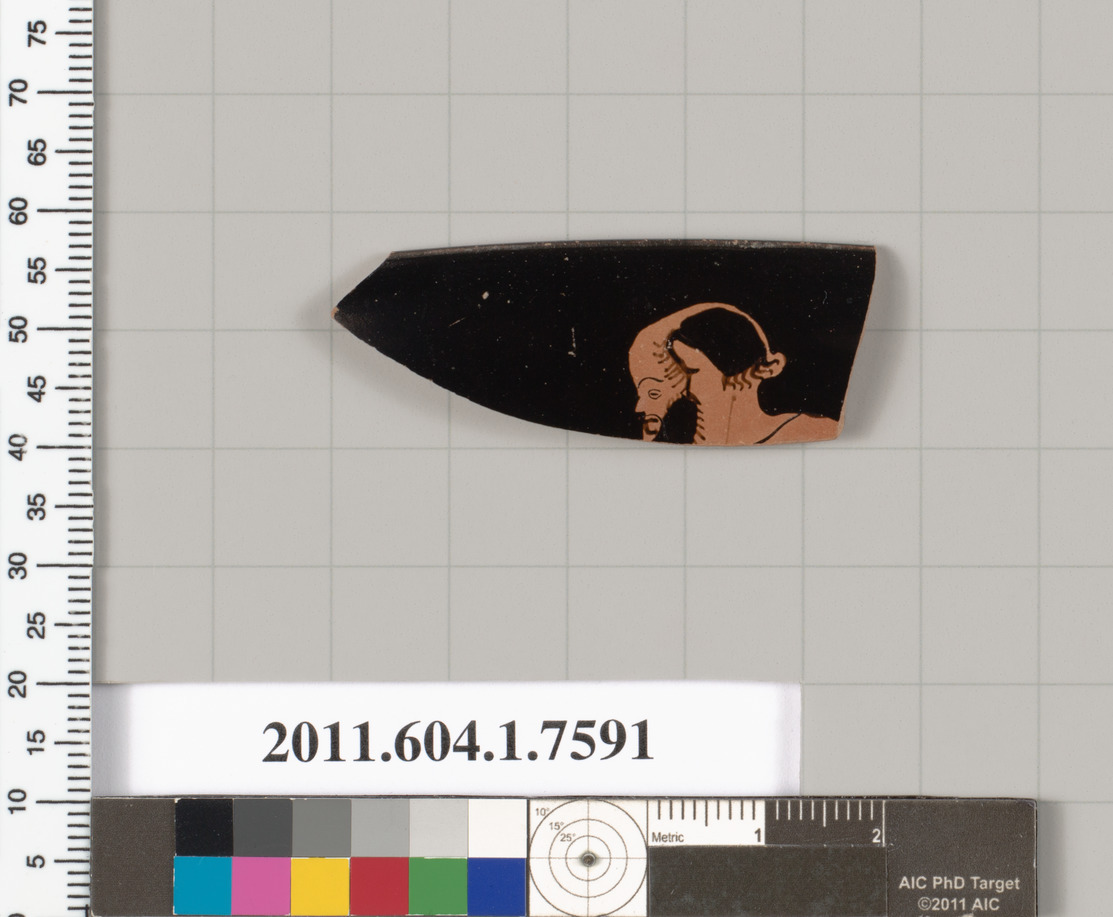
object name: kylix fragment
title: Terracotta rim fragment of a kylix (drinking cup)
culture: greek, attic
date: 460-450 BCE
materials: terracotta